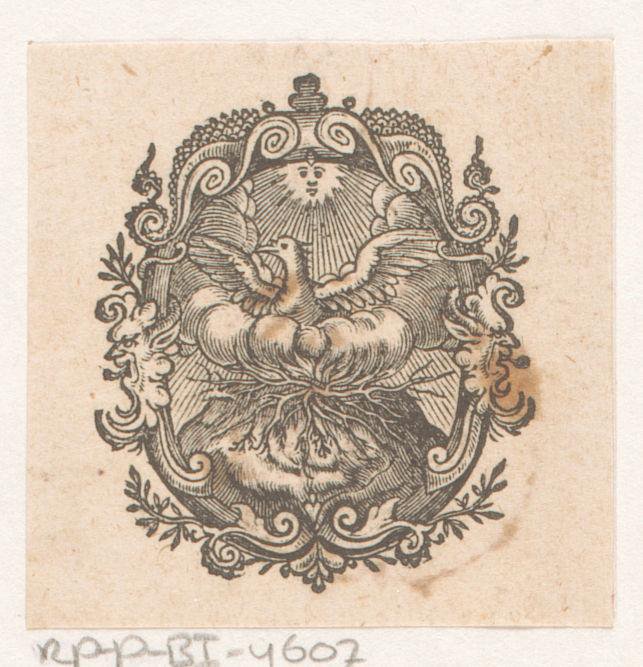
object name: print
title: Vignet met een brandende feniks in een nest die verrijst uit zijn eigen as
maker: Anonymous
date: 1600-1699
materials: paper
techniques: woodcut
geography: netherlands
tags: vignette, fabulous animals ~ birds: phoenix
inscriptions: collector's mark: Lugt 240